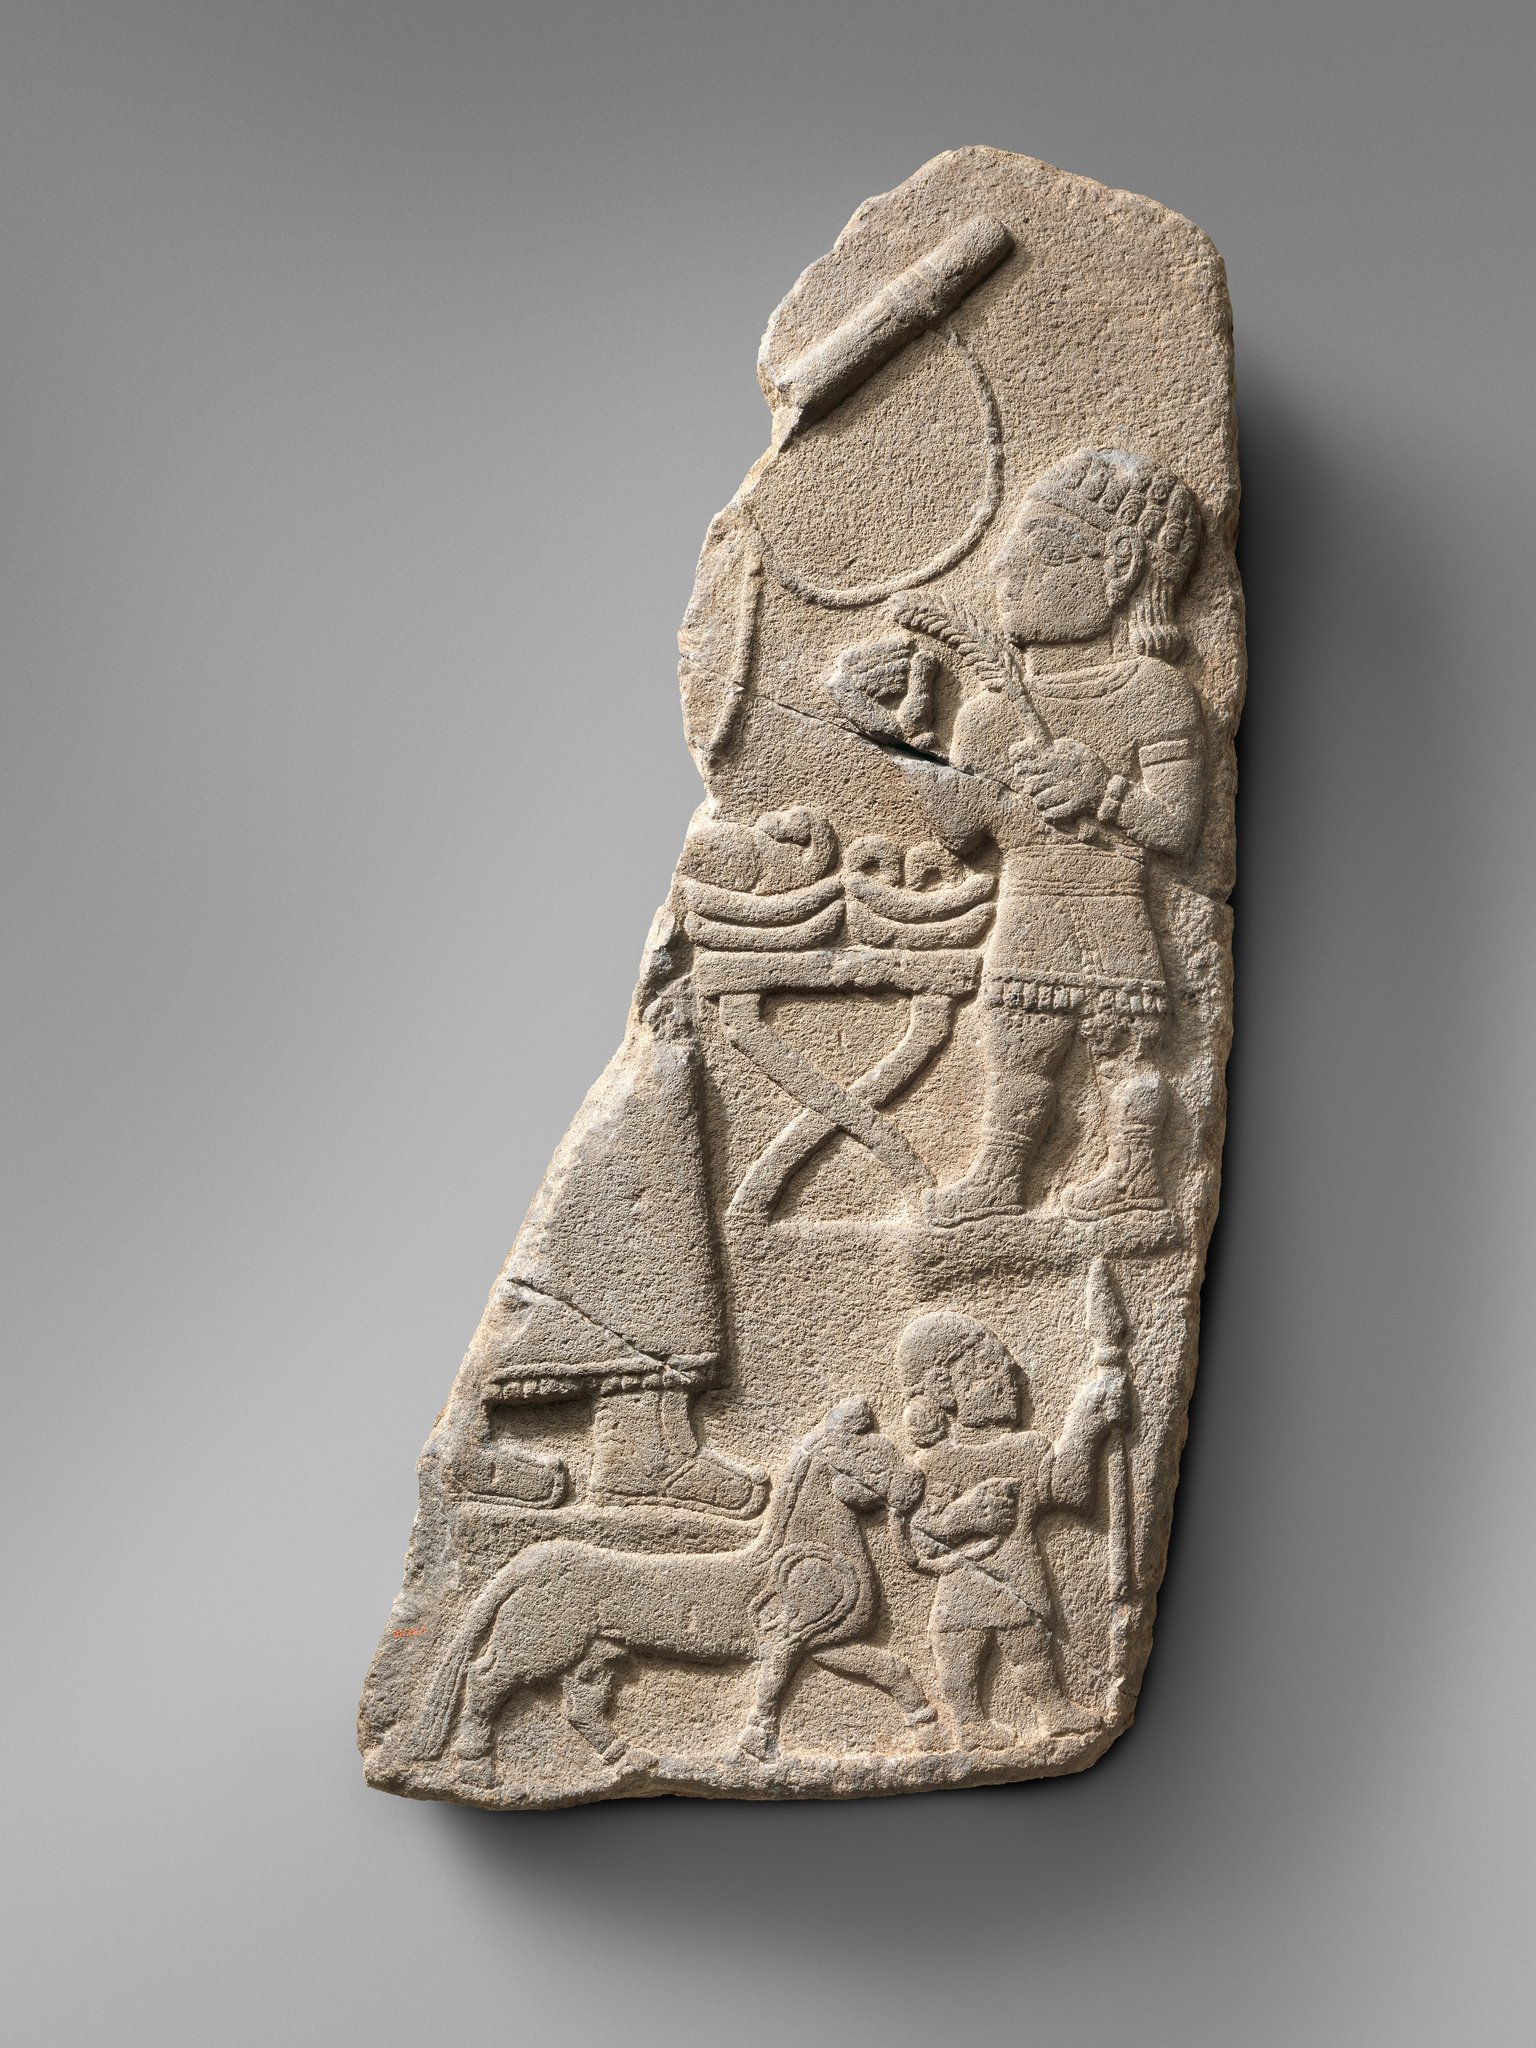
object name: relief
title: Relief fragment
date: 1000-668 BCE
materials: stone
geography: anatolia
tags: men,horses